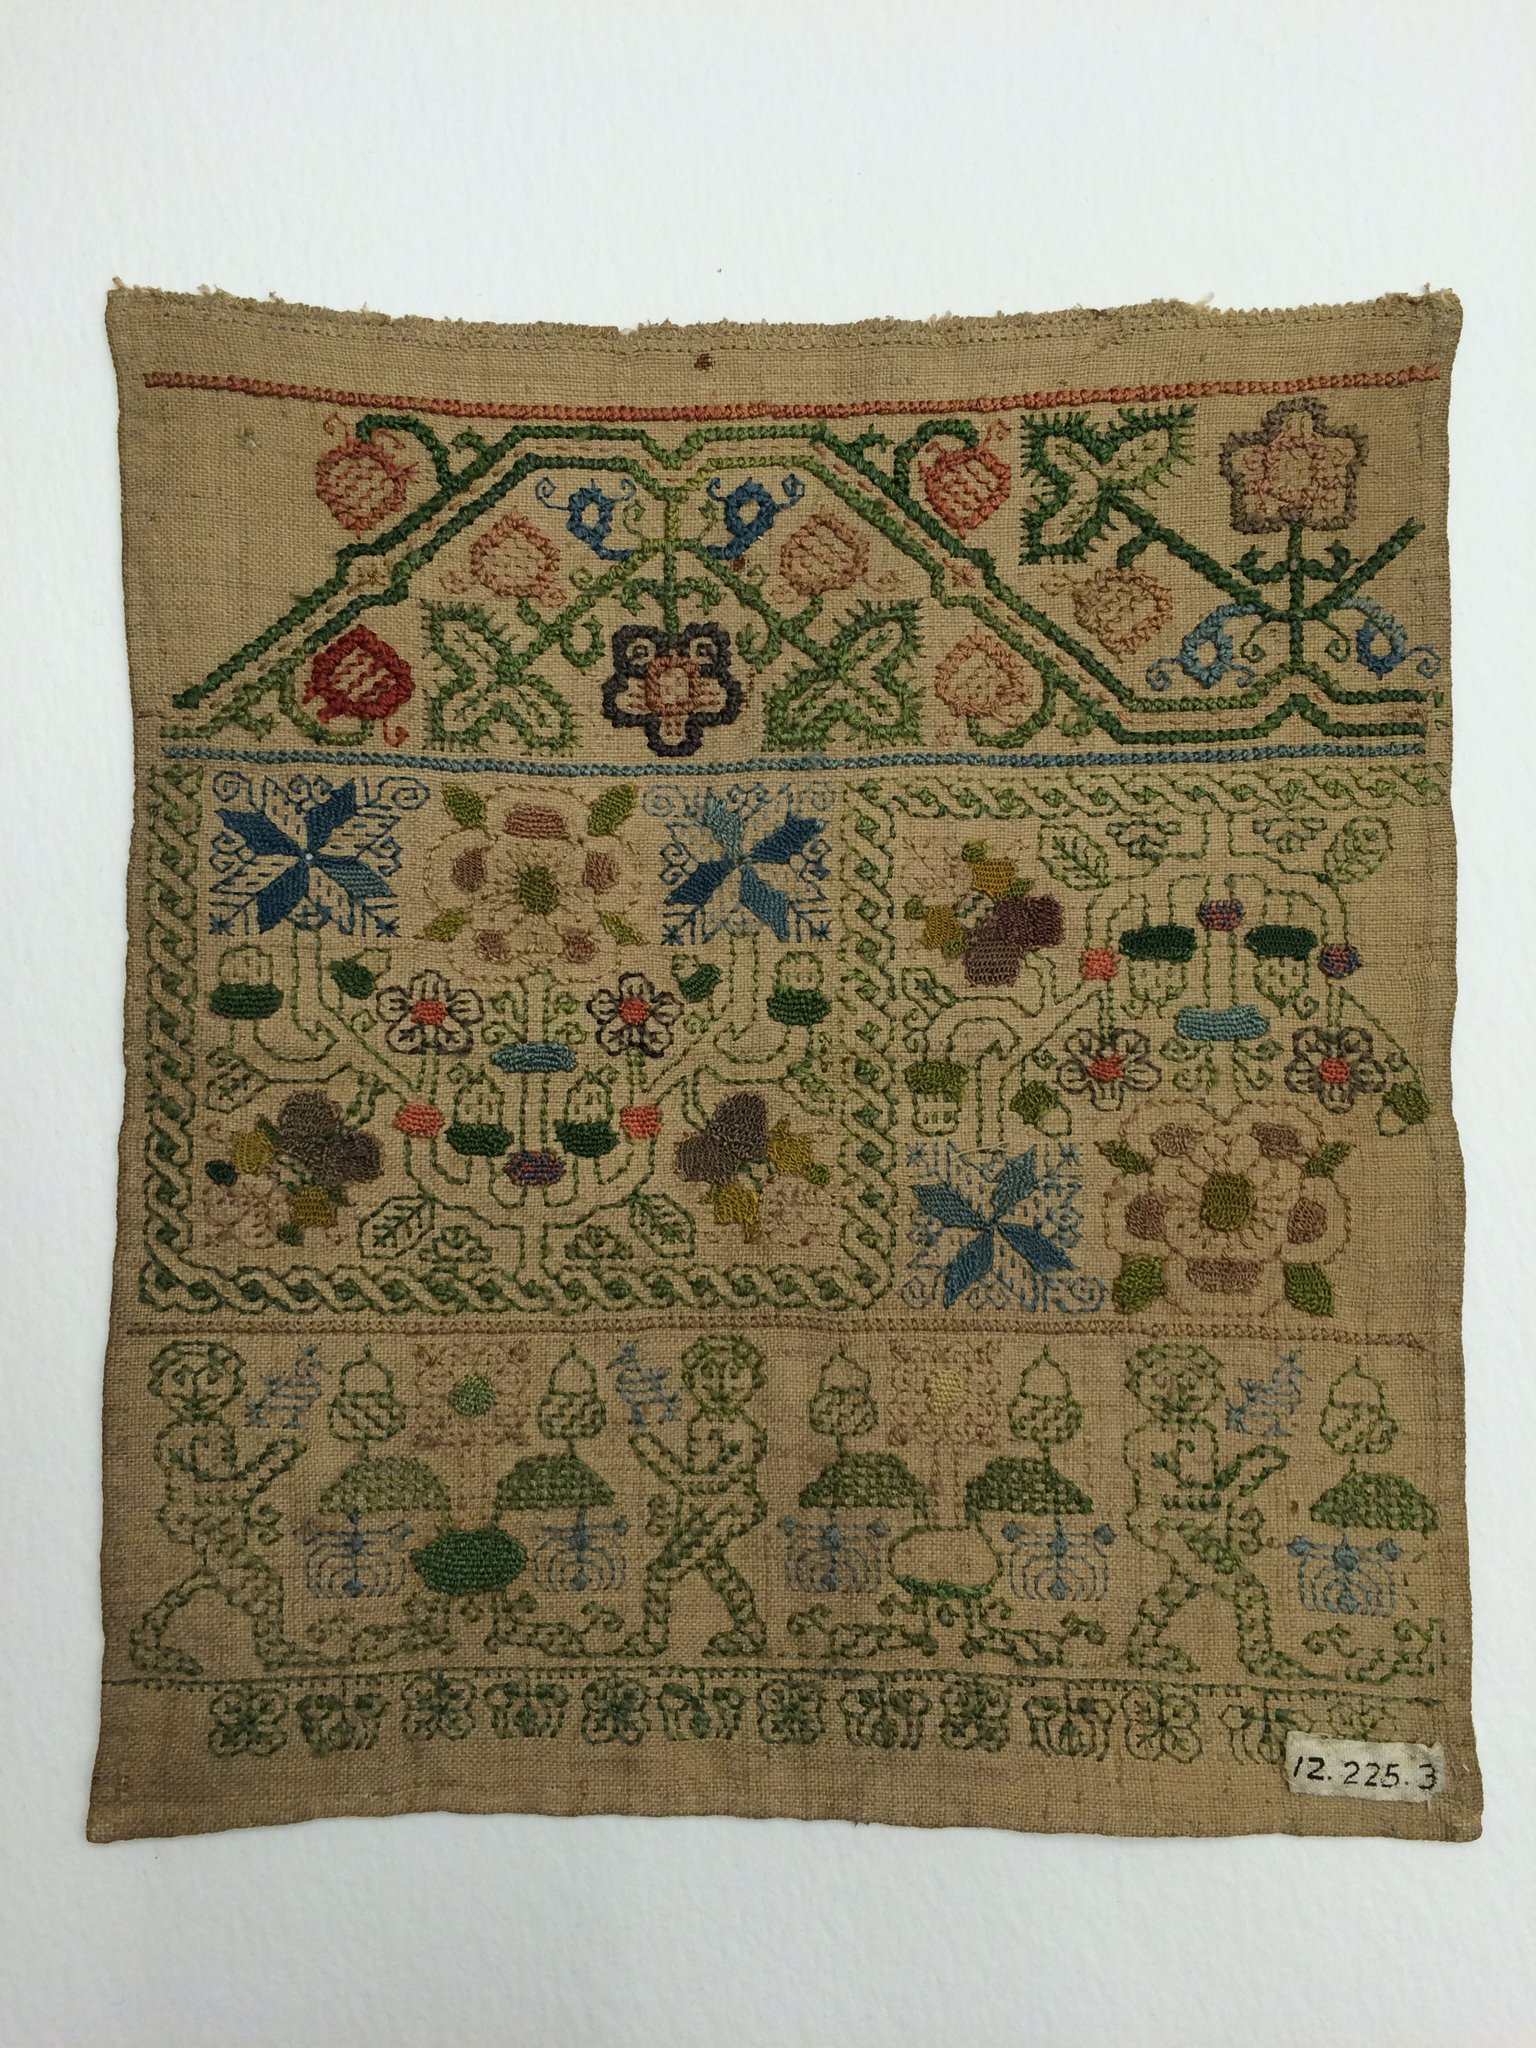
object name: sampler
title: Embroidered band sampler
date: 1650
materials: linen, silk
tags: men,flowers